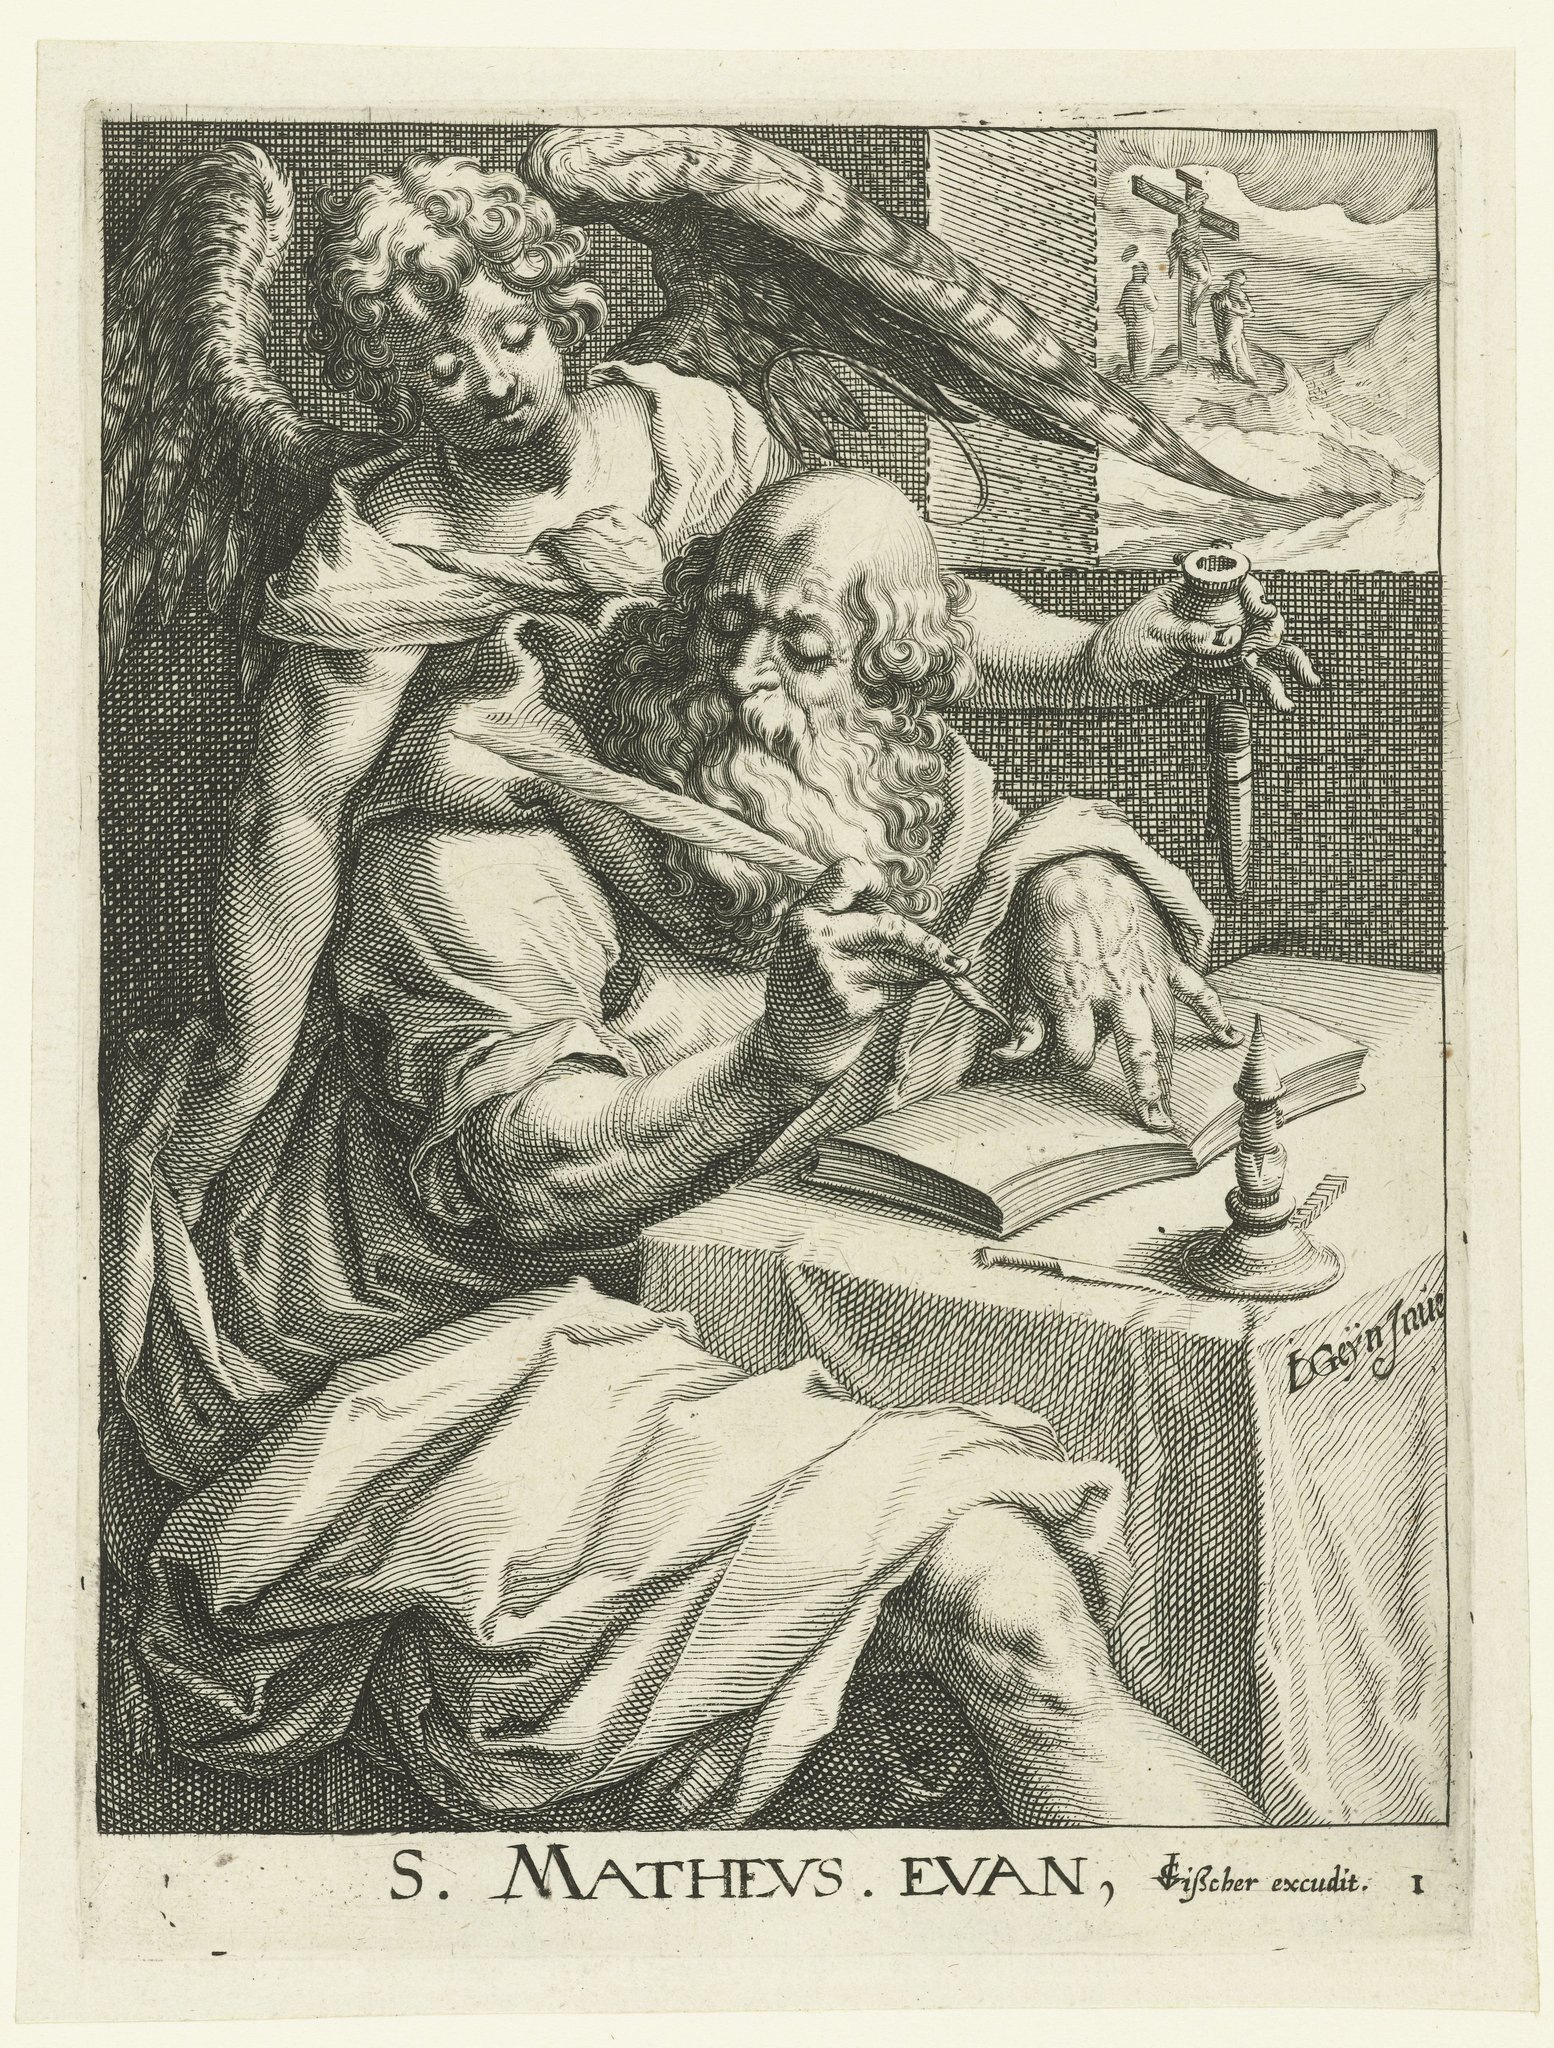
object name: print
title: De vier evangelisten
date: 1593-1597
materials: paper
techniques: engraving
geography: netherlands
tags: the apostle and evangelist matthew (mattheus); possible attributes: angel, axe, book, halberd, pen and inkhorn, purse, scroll, square, sword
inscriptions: collector's mark: Lugt 2228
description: Mattheüs de evangelist, gezeten, schrijvend in een boek. Een engel houdt hem vanachter zijn rug een inktpot voor. Onder de voorstelling de tekst 'S. Mathevs. evan,' en het adres van de uitgever. Deze prent is onderdeel van een serie van vier voorstellingen van de evangelisten, elk met de naam van de betreffende evangelist als onderschrift.